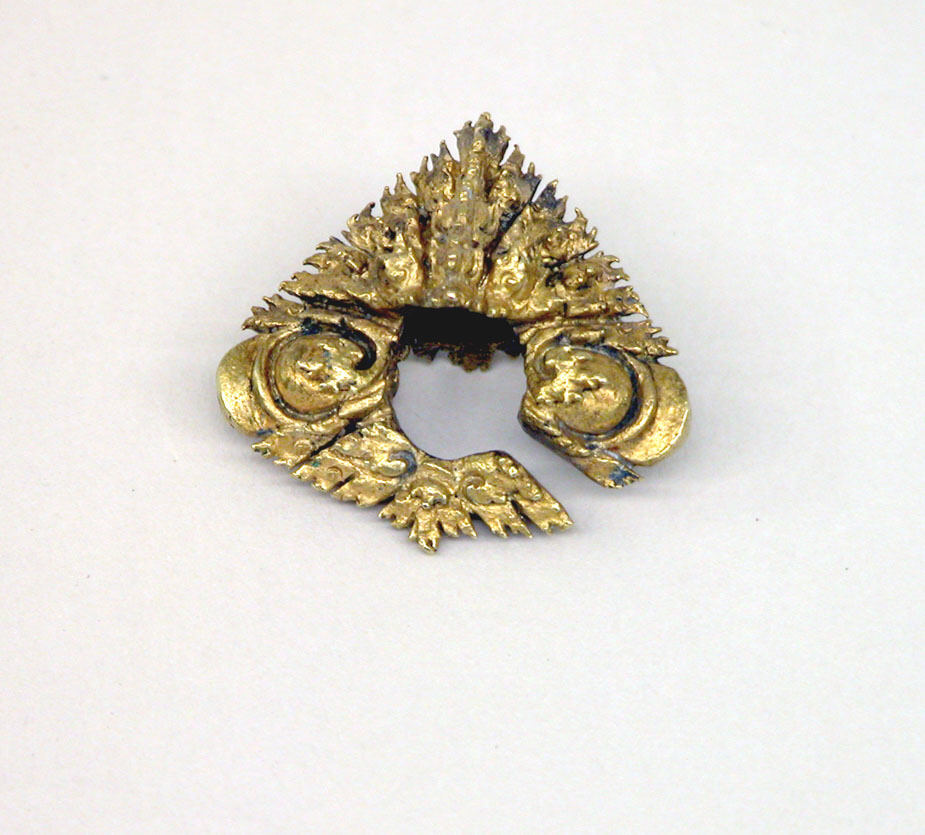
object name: ear ornament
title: Pair of Ear Ornaments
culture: indonesian, javanese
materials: gold